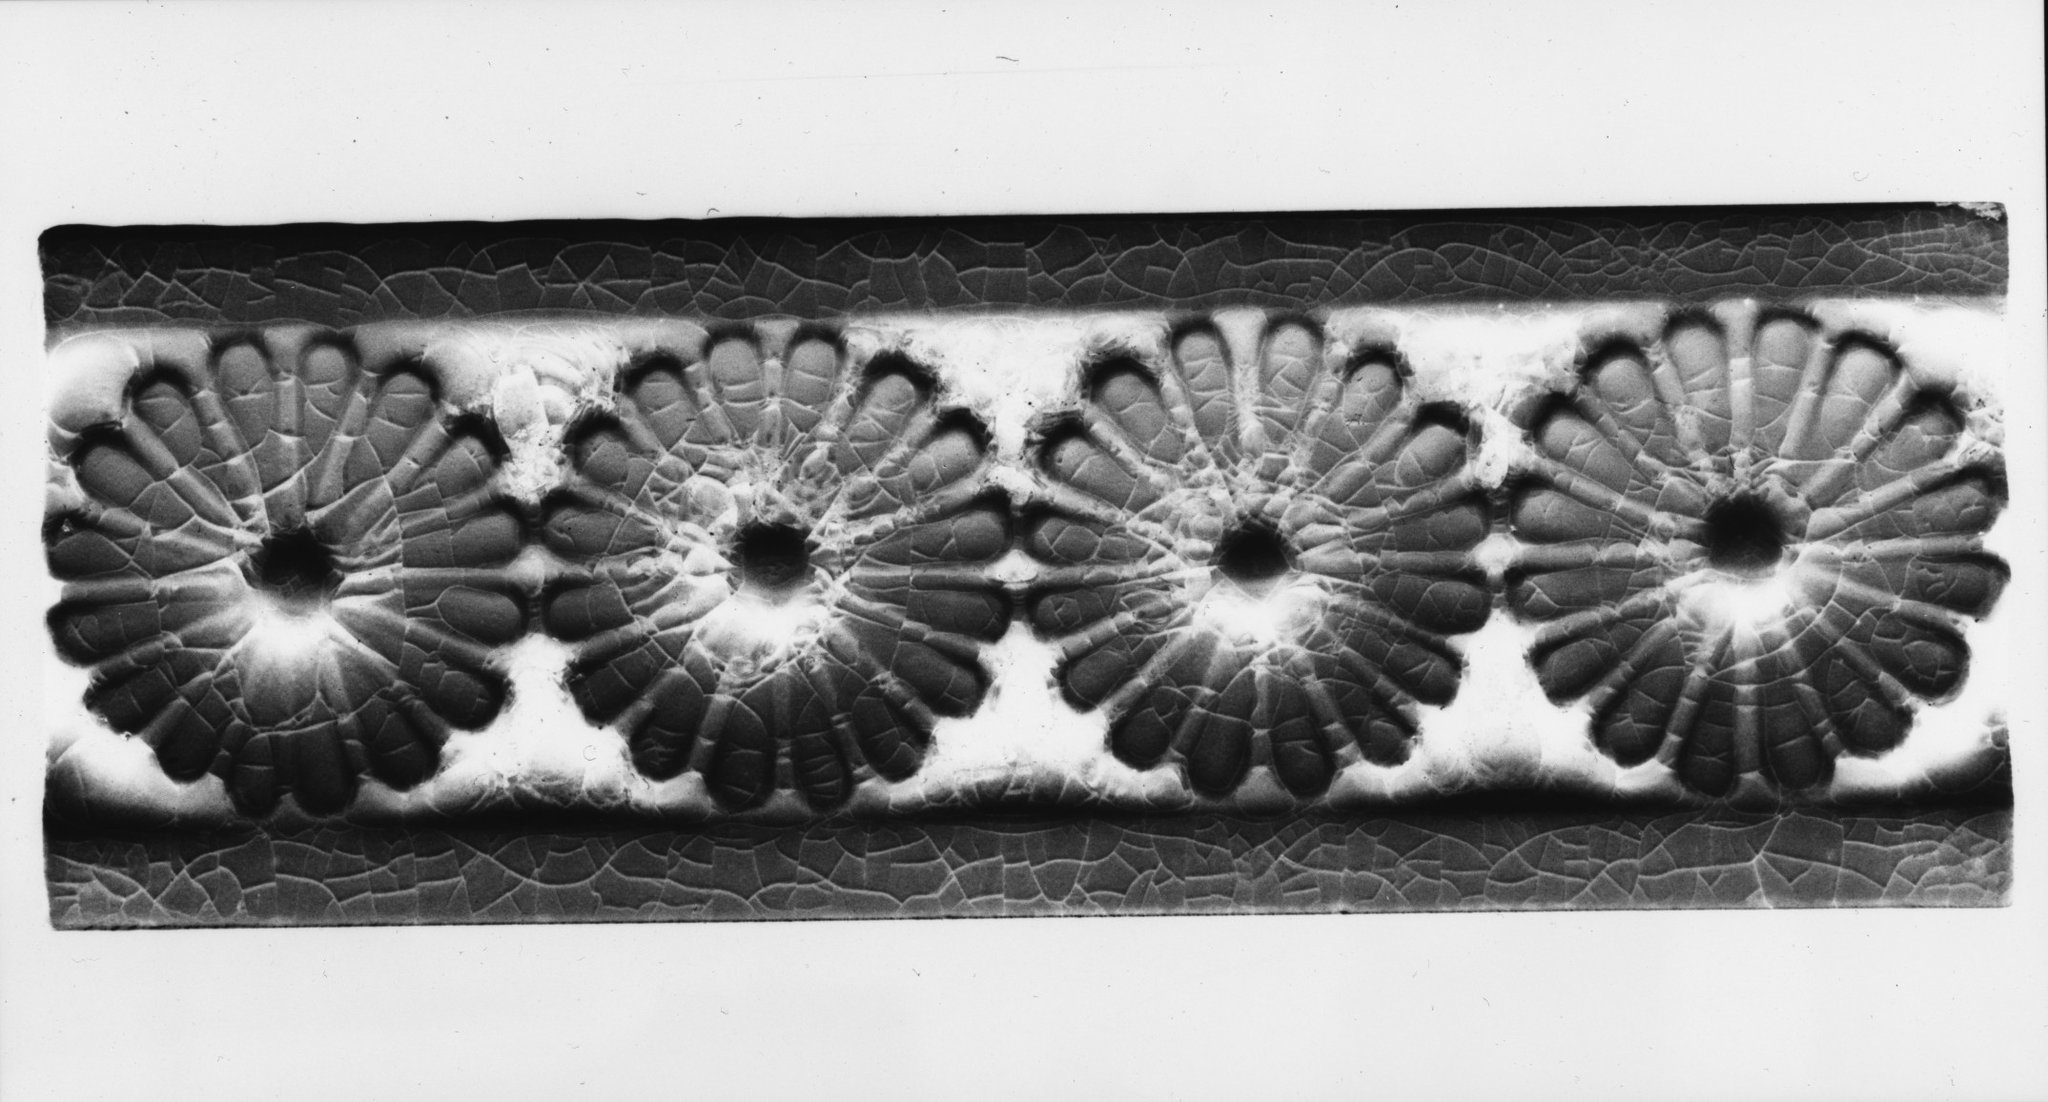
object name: tile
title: Border Tile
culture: american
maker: j. and j. g. low art tile works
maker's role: maker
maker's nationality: american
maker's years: 1877-1903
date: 1881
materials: earthenware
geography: united states